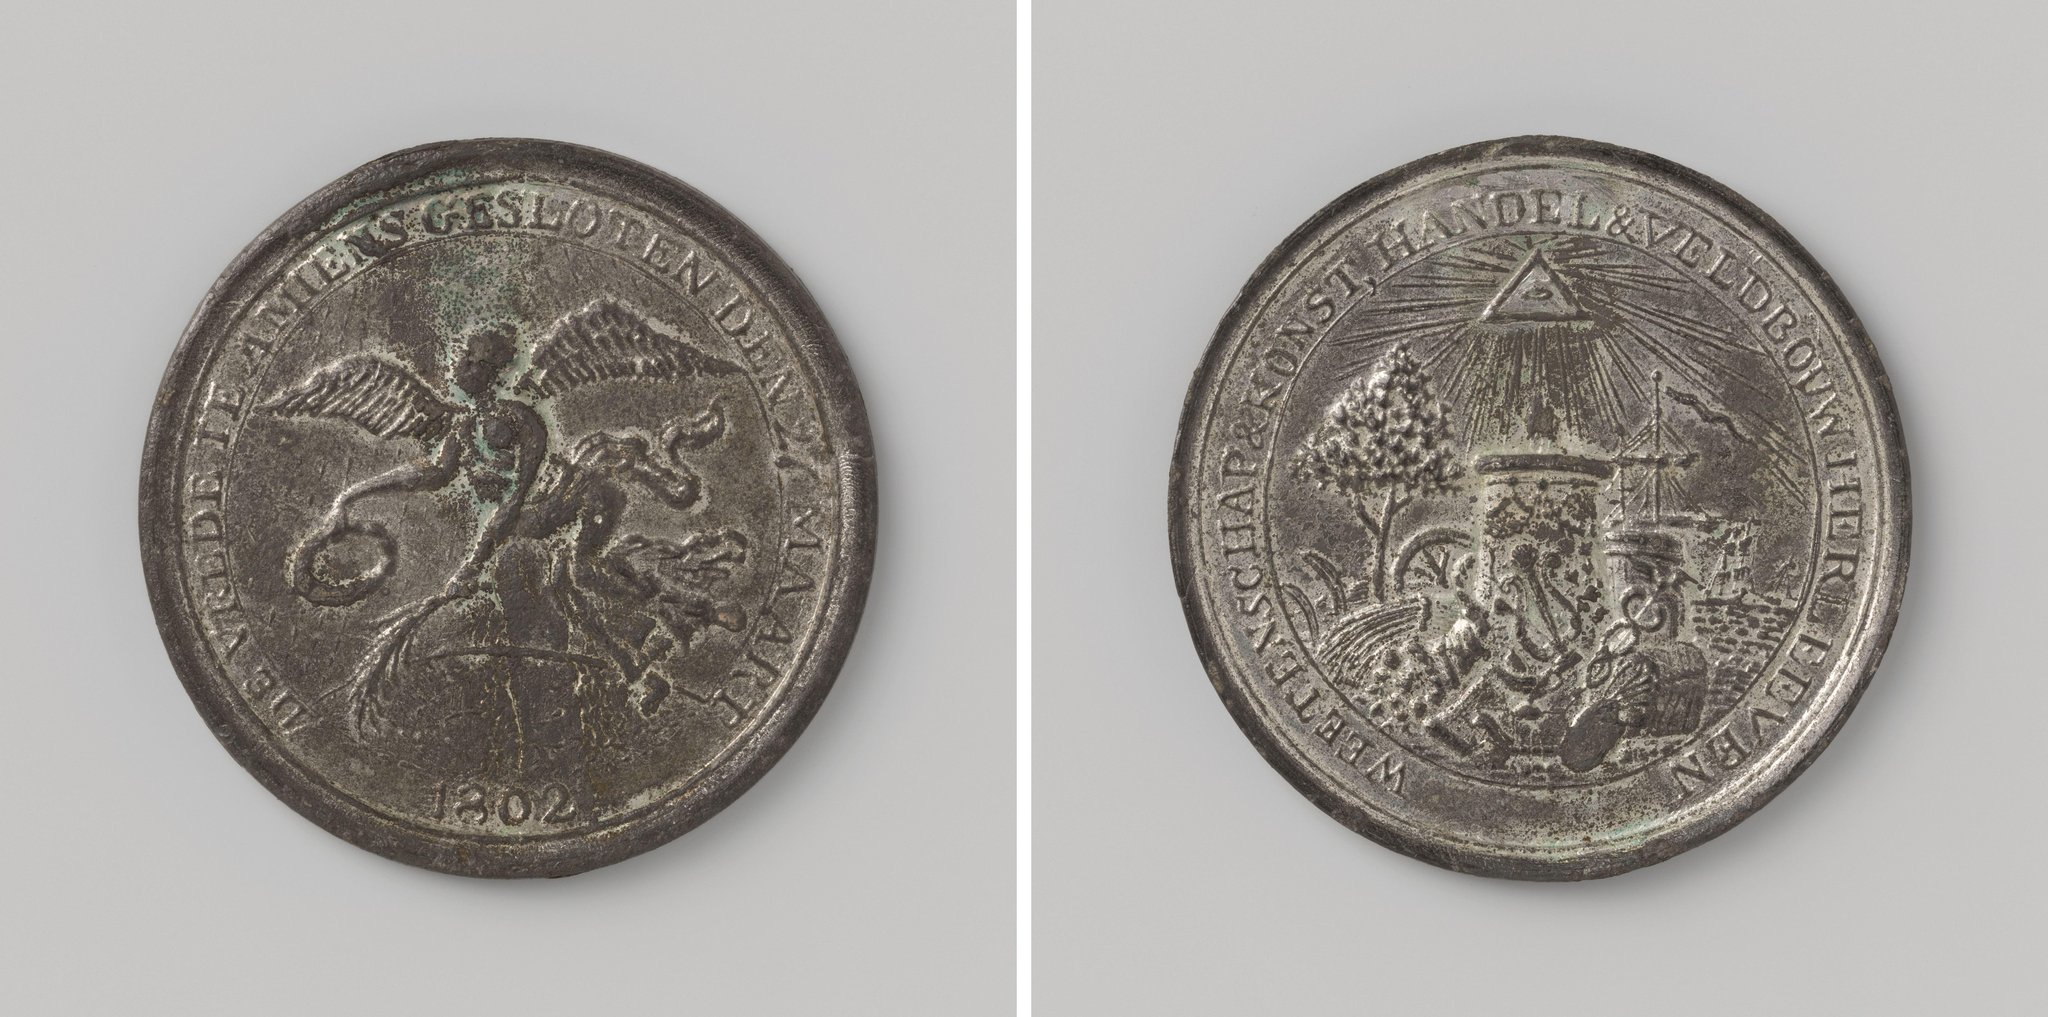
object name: copy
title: Vrede van Amiens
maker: Anonymous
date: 1802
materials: lead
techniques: striking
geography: netherlands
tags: amiens, vrede van amiens (1802)